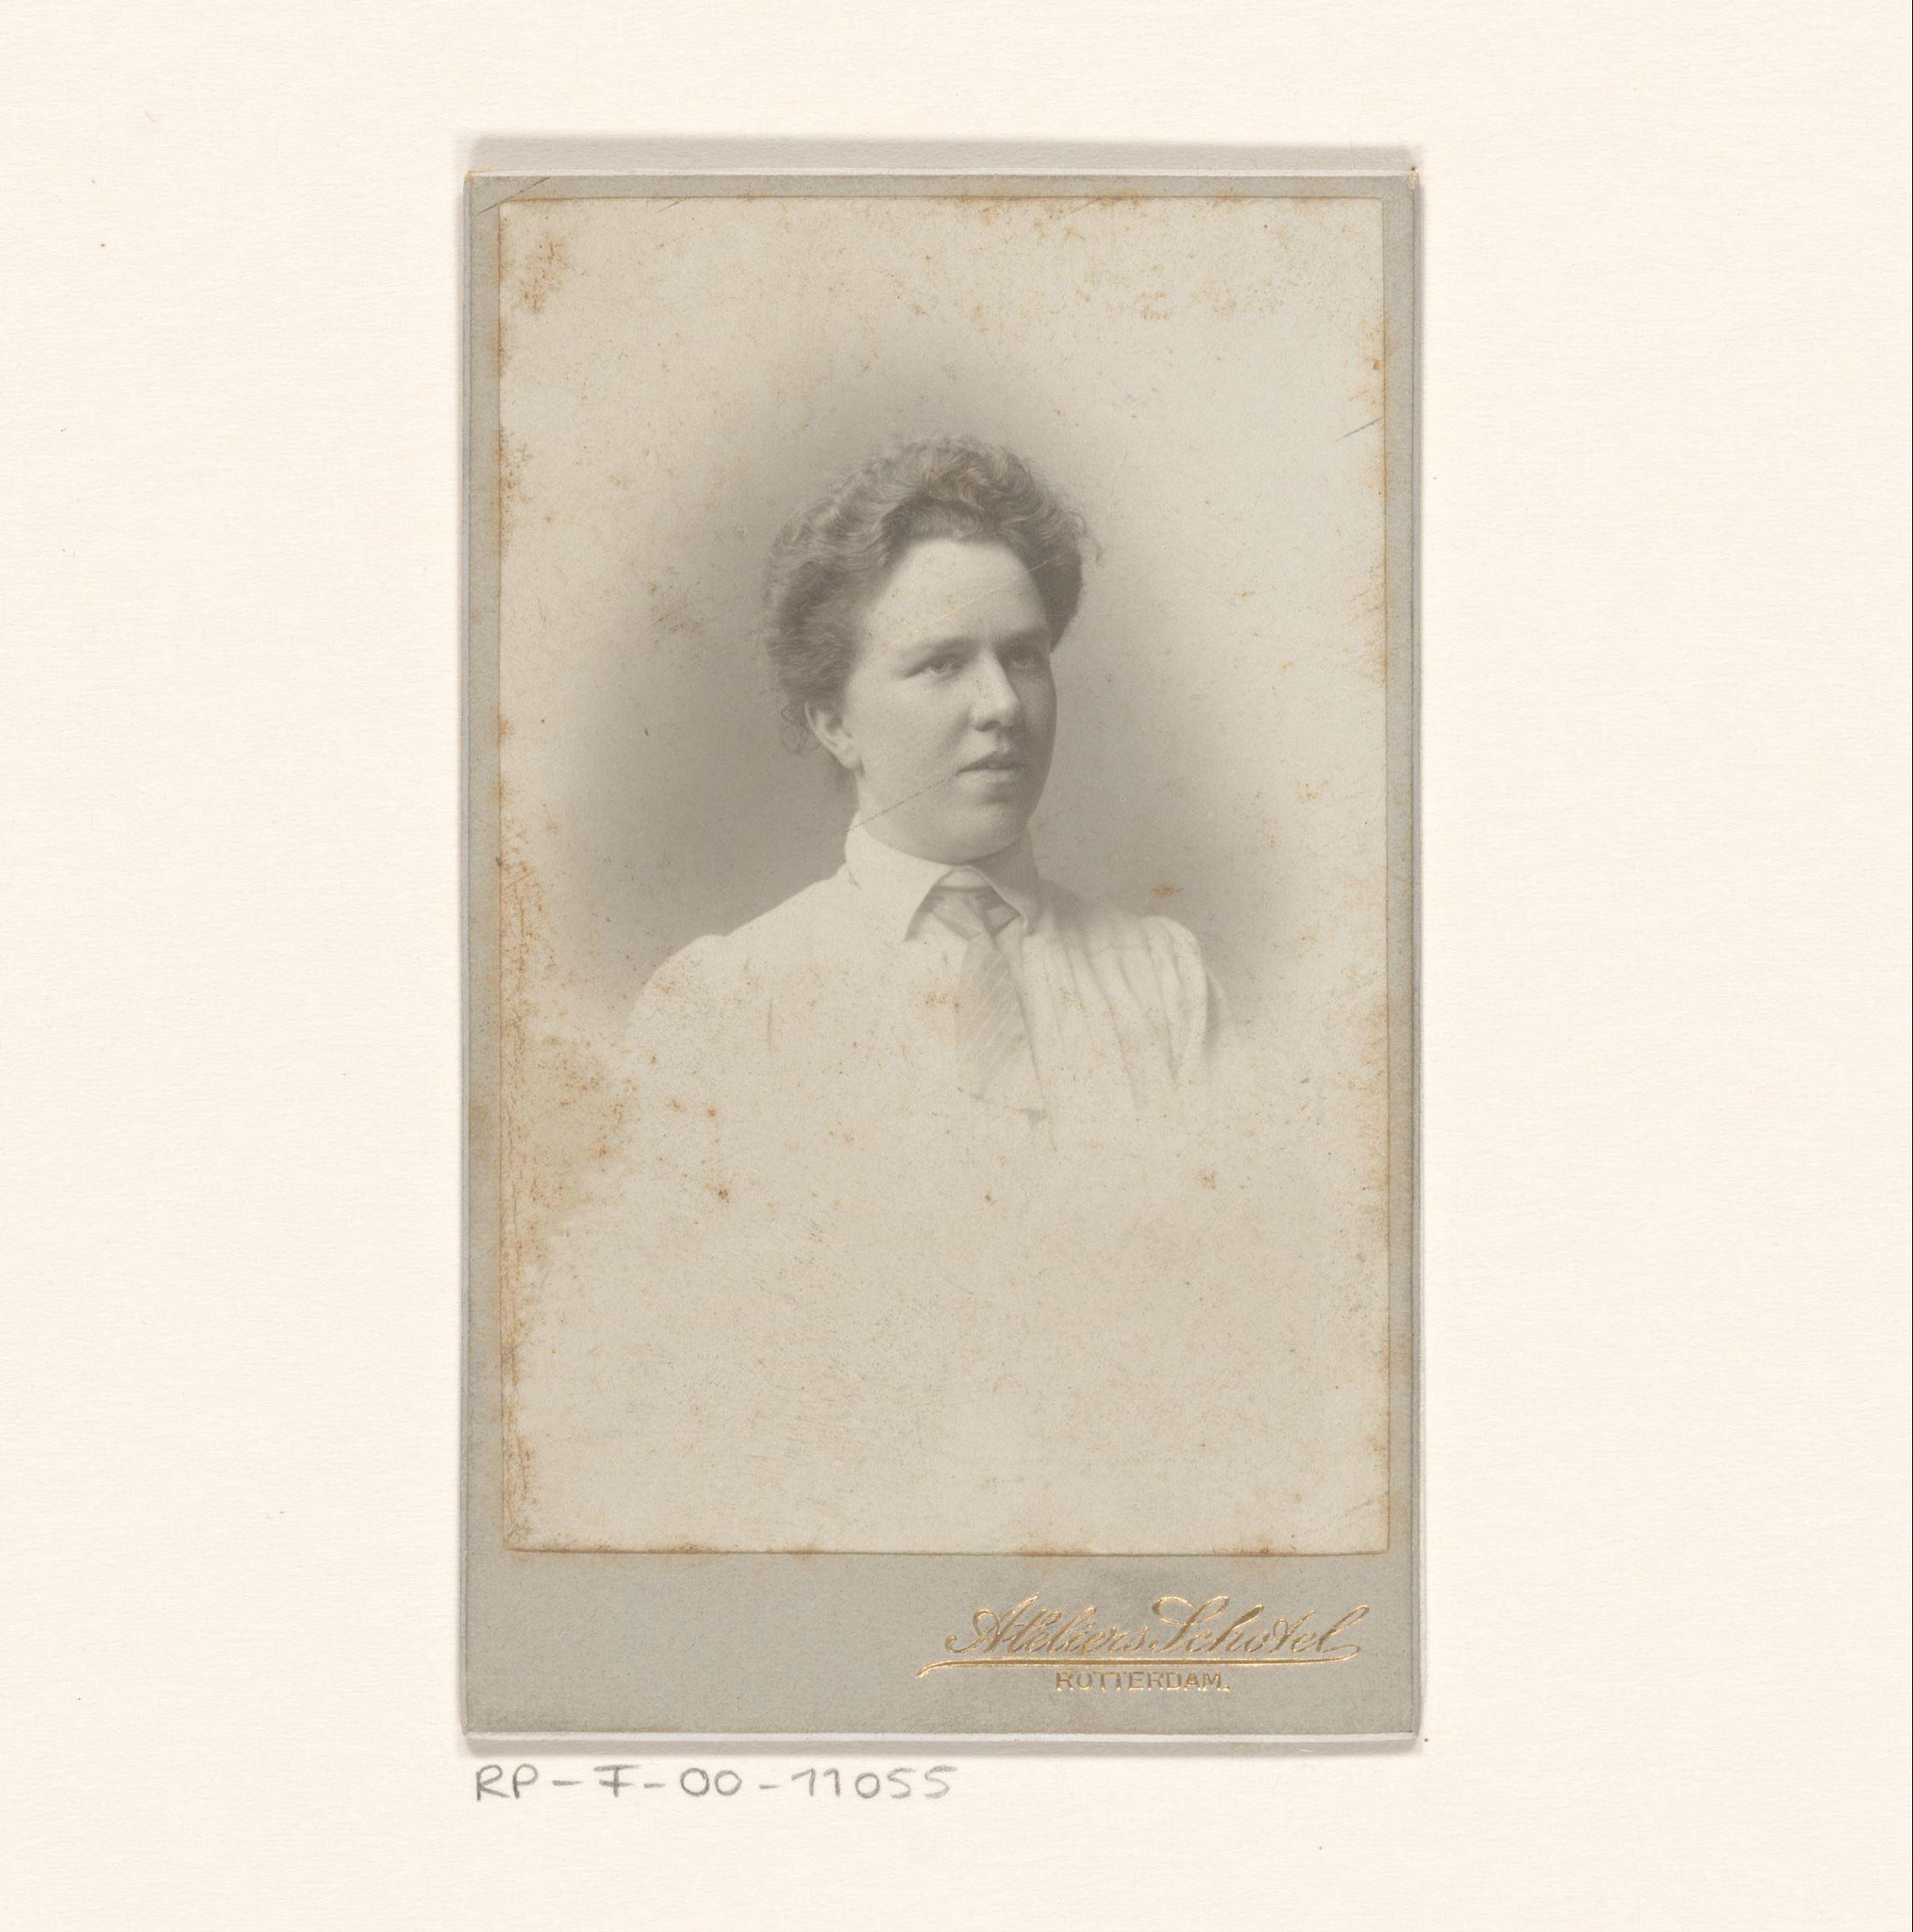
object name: carte de visite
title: Portret van Nannie van Wehl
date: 1890-1944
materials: cardboard, photographic support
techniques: collodion silver print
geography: rotterdam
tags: the hague, portrait of a writer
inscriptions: :, inscription: ‘Atelier Schotel/ ROTTERDAM’, name: ‘S.J.A. Reijs.’, collector's mark: Lugt 2228a